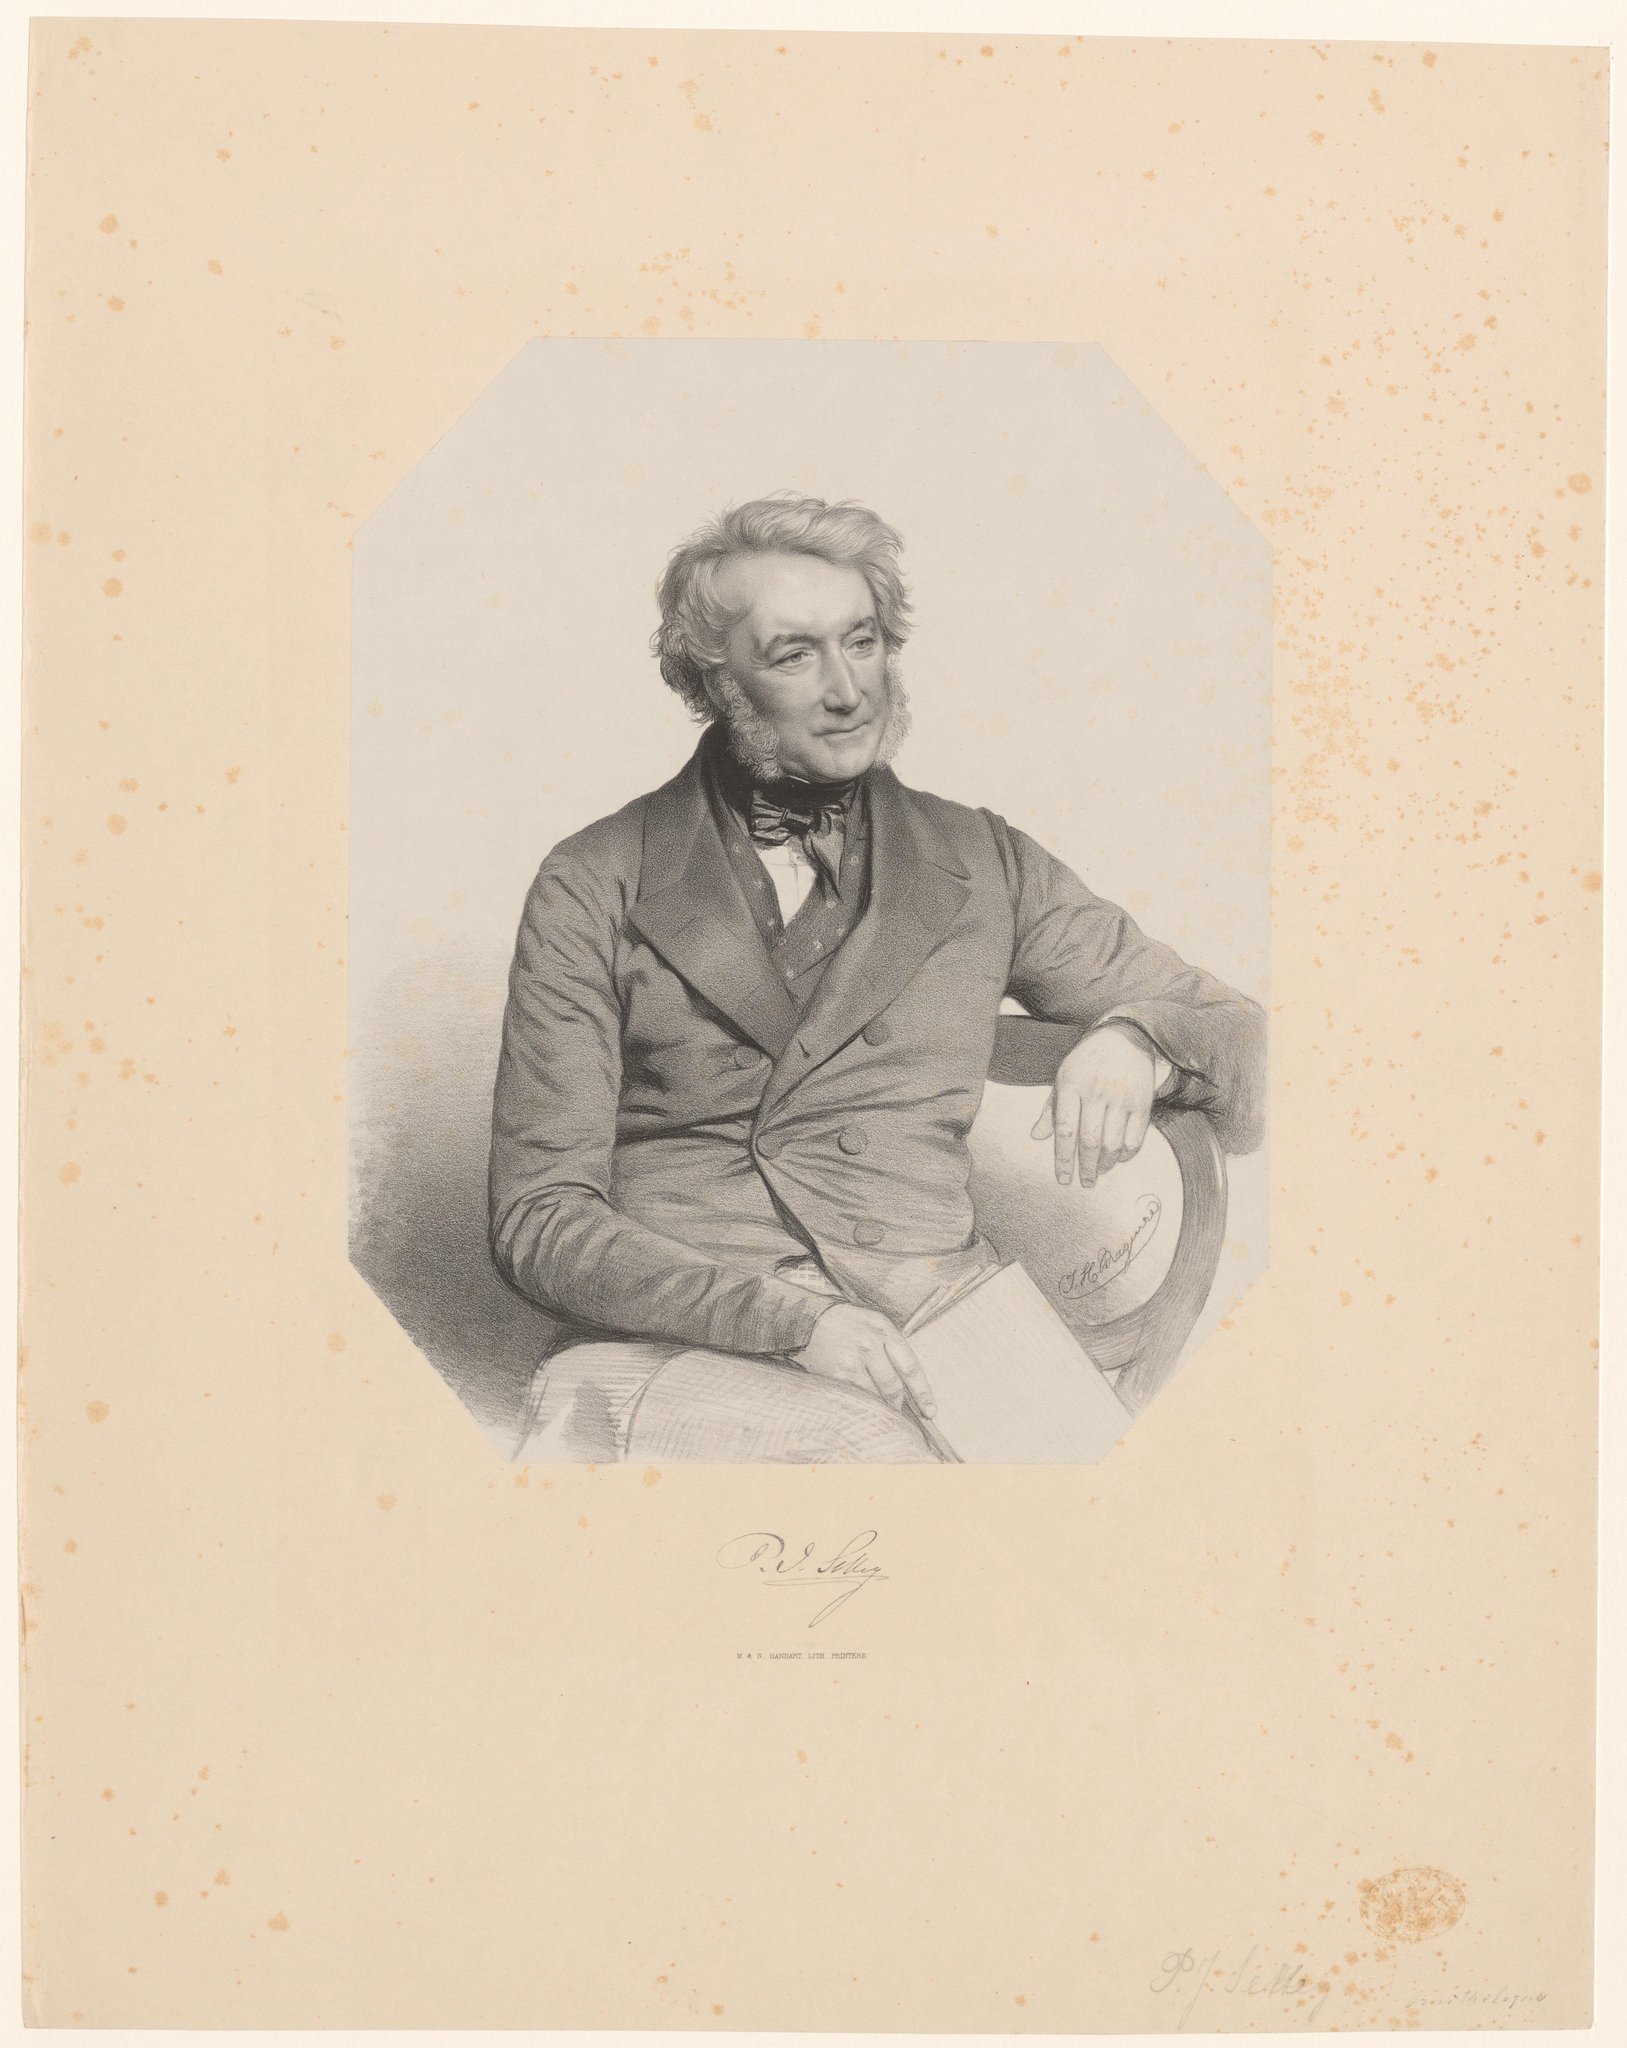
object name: print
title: Ipswich Museum Portraits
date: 1852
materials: paper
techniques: lithograph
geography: london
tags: adult man, historical persons, book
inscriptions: collector's mark: Lugt 2228, check stamp: ‘Ipswich Museum’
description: Prent behoort tot de serie 'Ipswich Museum Portraits', ook bekend onder de titel 'Portraits of Honorary Members of the Ipswich Museum'. Deze serie is in 1852 door George Ransome uitgegeven en gedrukt door M&N Hanhart tussen 1848 en 1852. De serie bestaat uit ca. 60 portretten.